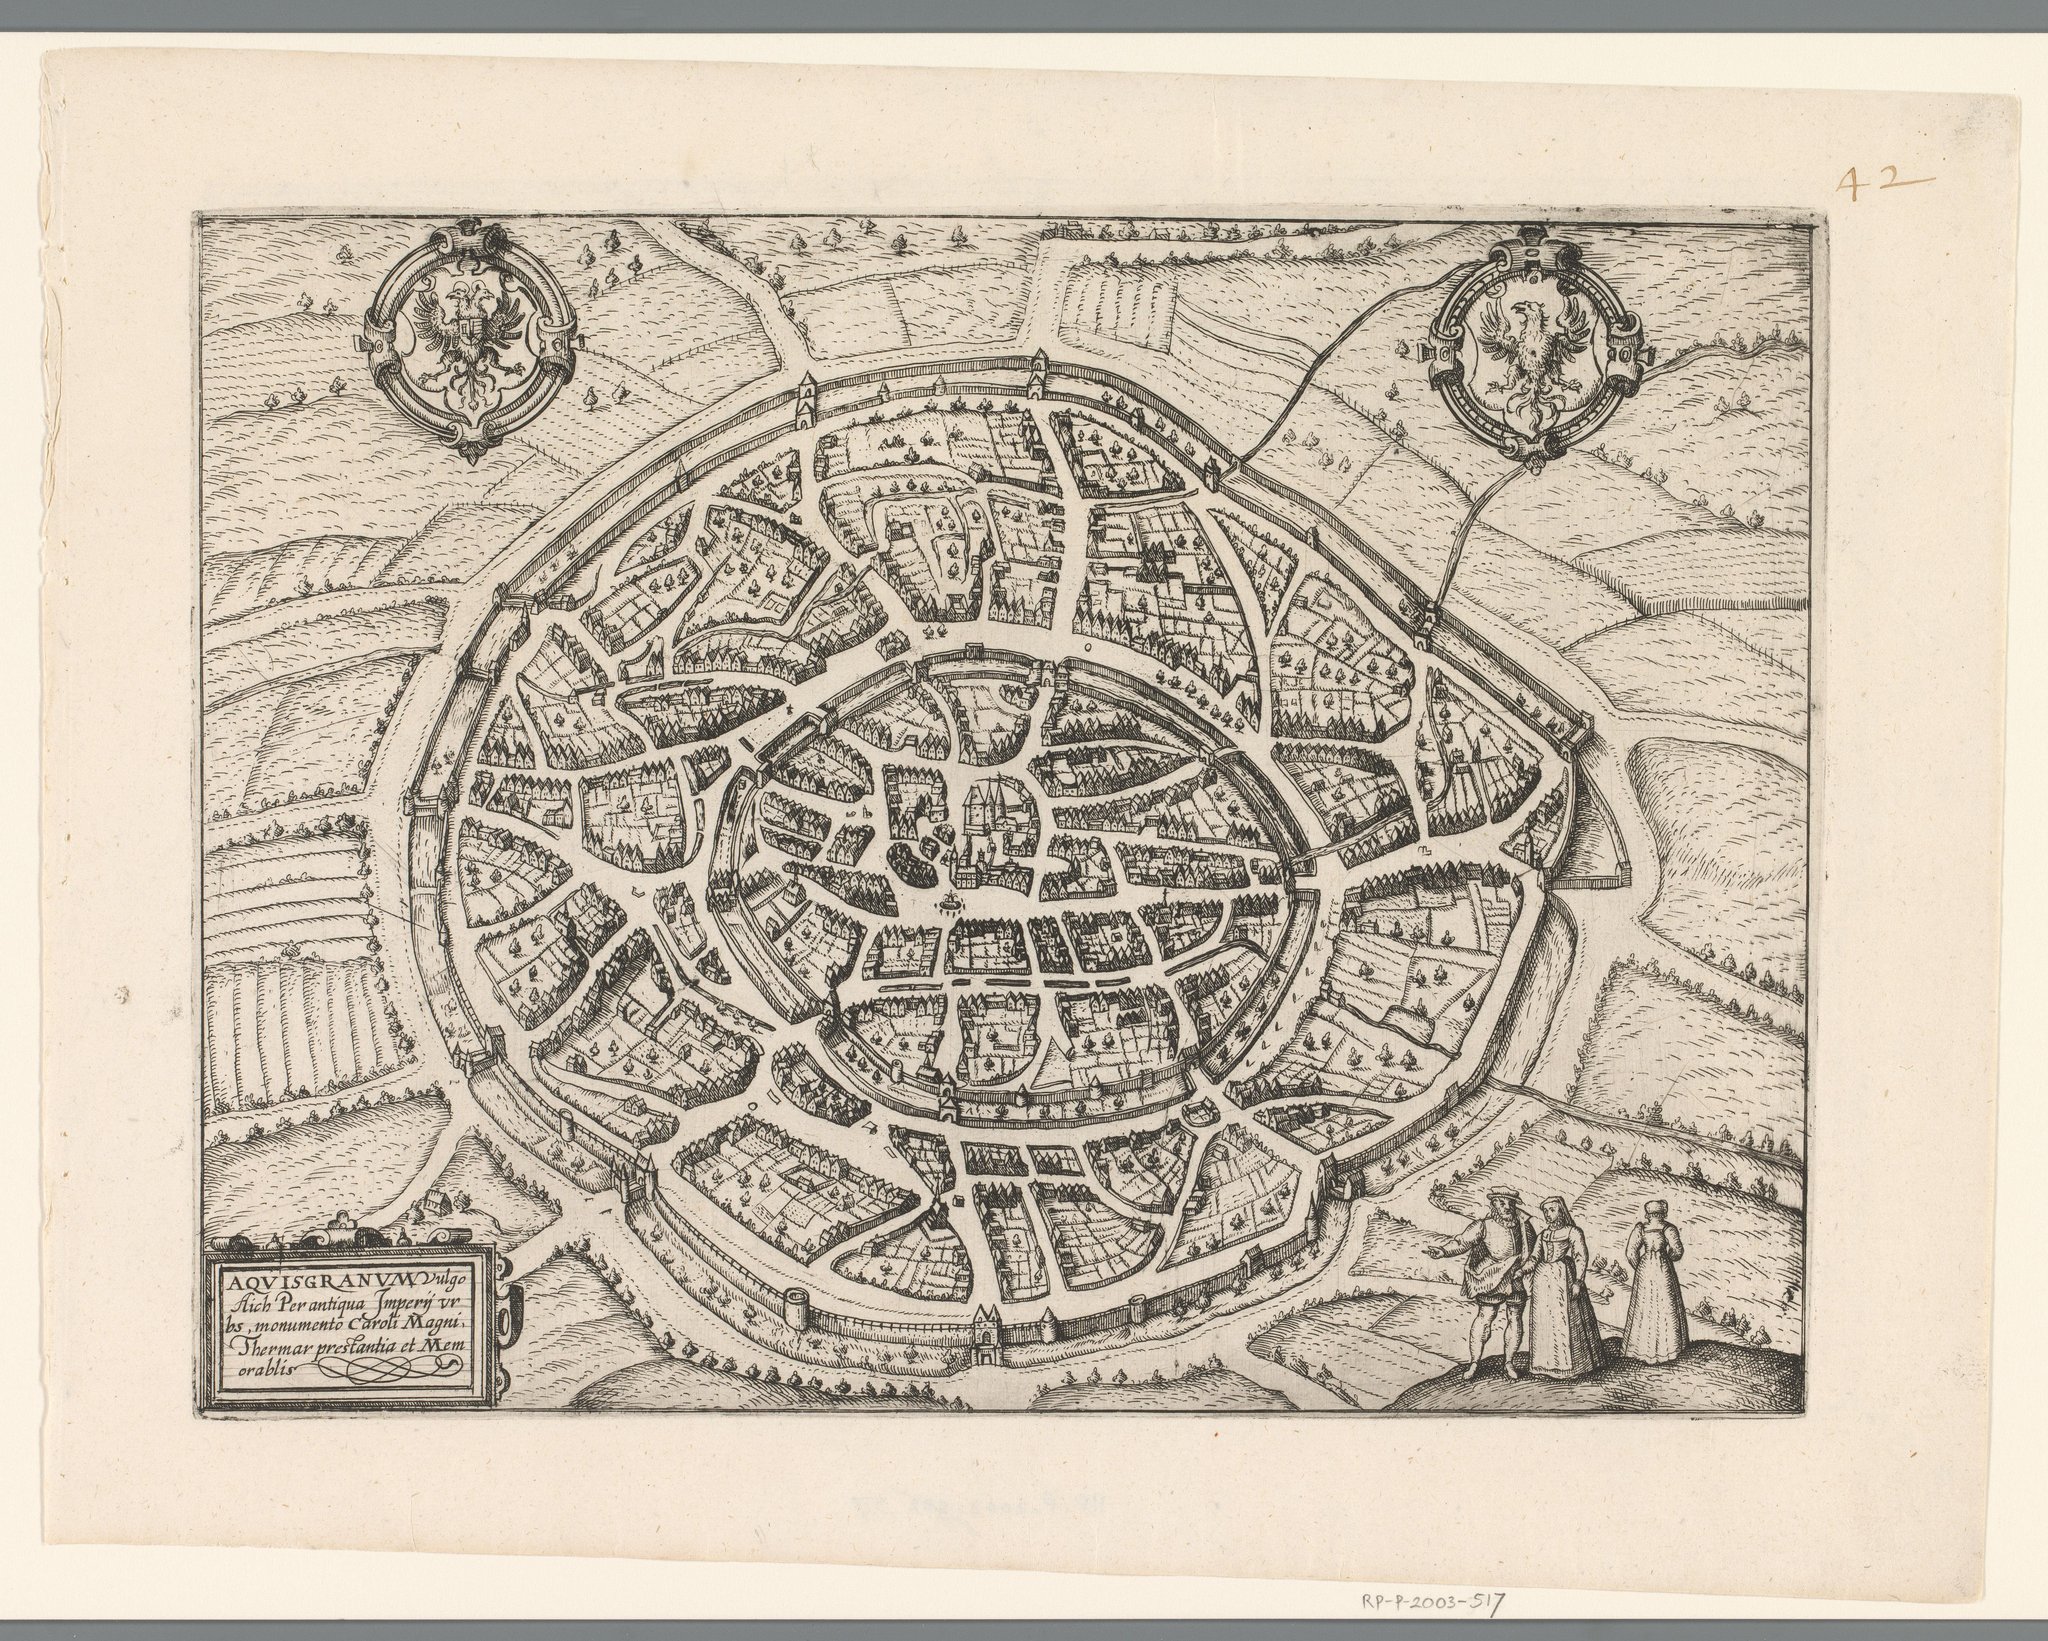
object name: print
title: Aquisgranum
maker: Anonymous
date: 1607-1609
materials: paper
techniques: etching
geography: southern netherlands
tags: maps of cities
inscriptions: number: ‘42’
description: Plattegrond van de stad Aken (Aachen). Linksboven het rijkswapen met de dubbele adelaar, rechtsboven het stadswapen. Linksonder een cartouche met de Latijnse titel. Rechtsonder een man en twee vrouwen. Onderdeel van de verzameling kaarten genomen uit een latere editie van: Descrittione di tutti i Paesi Bassi van Lodovico Guicciardini.